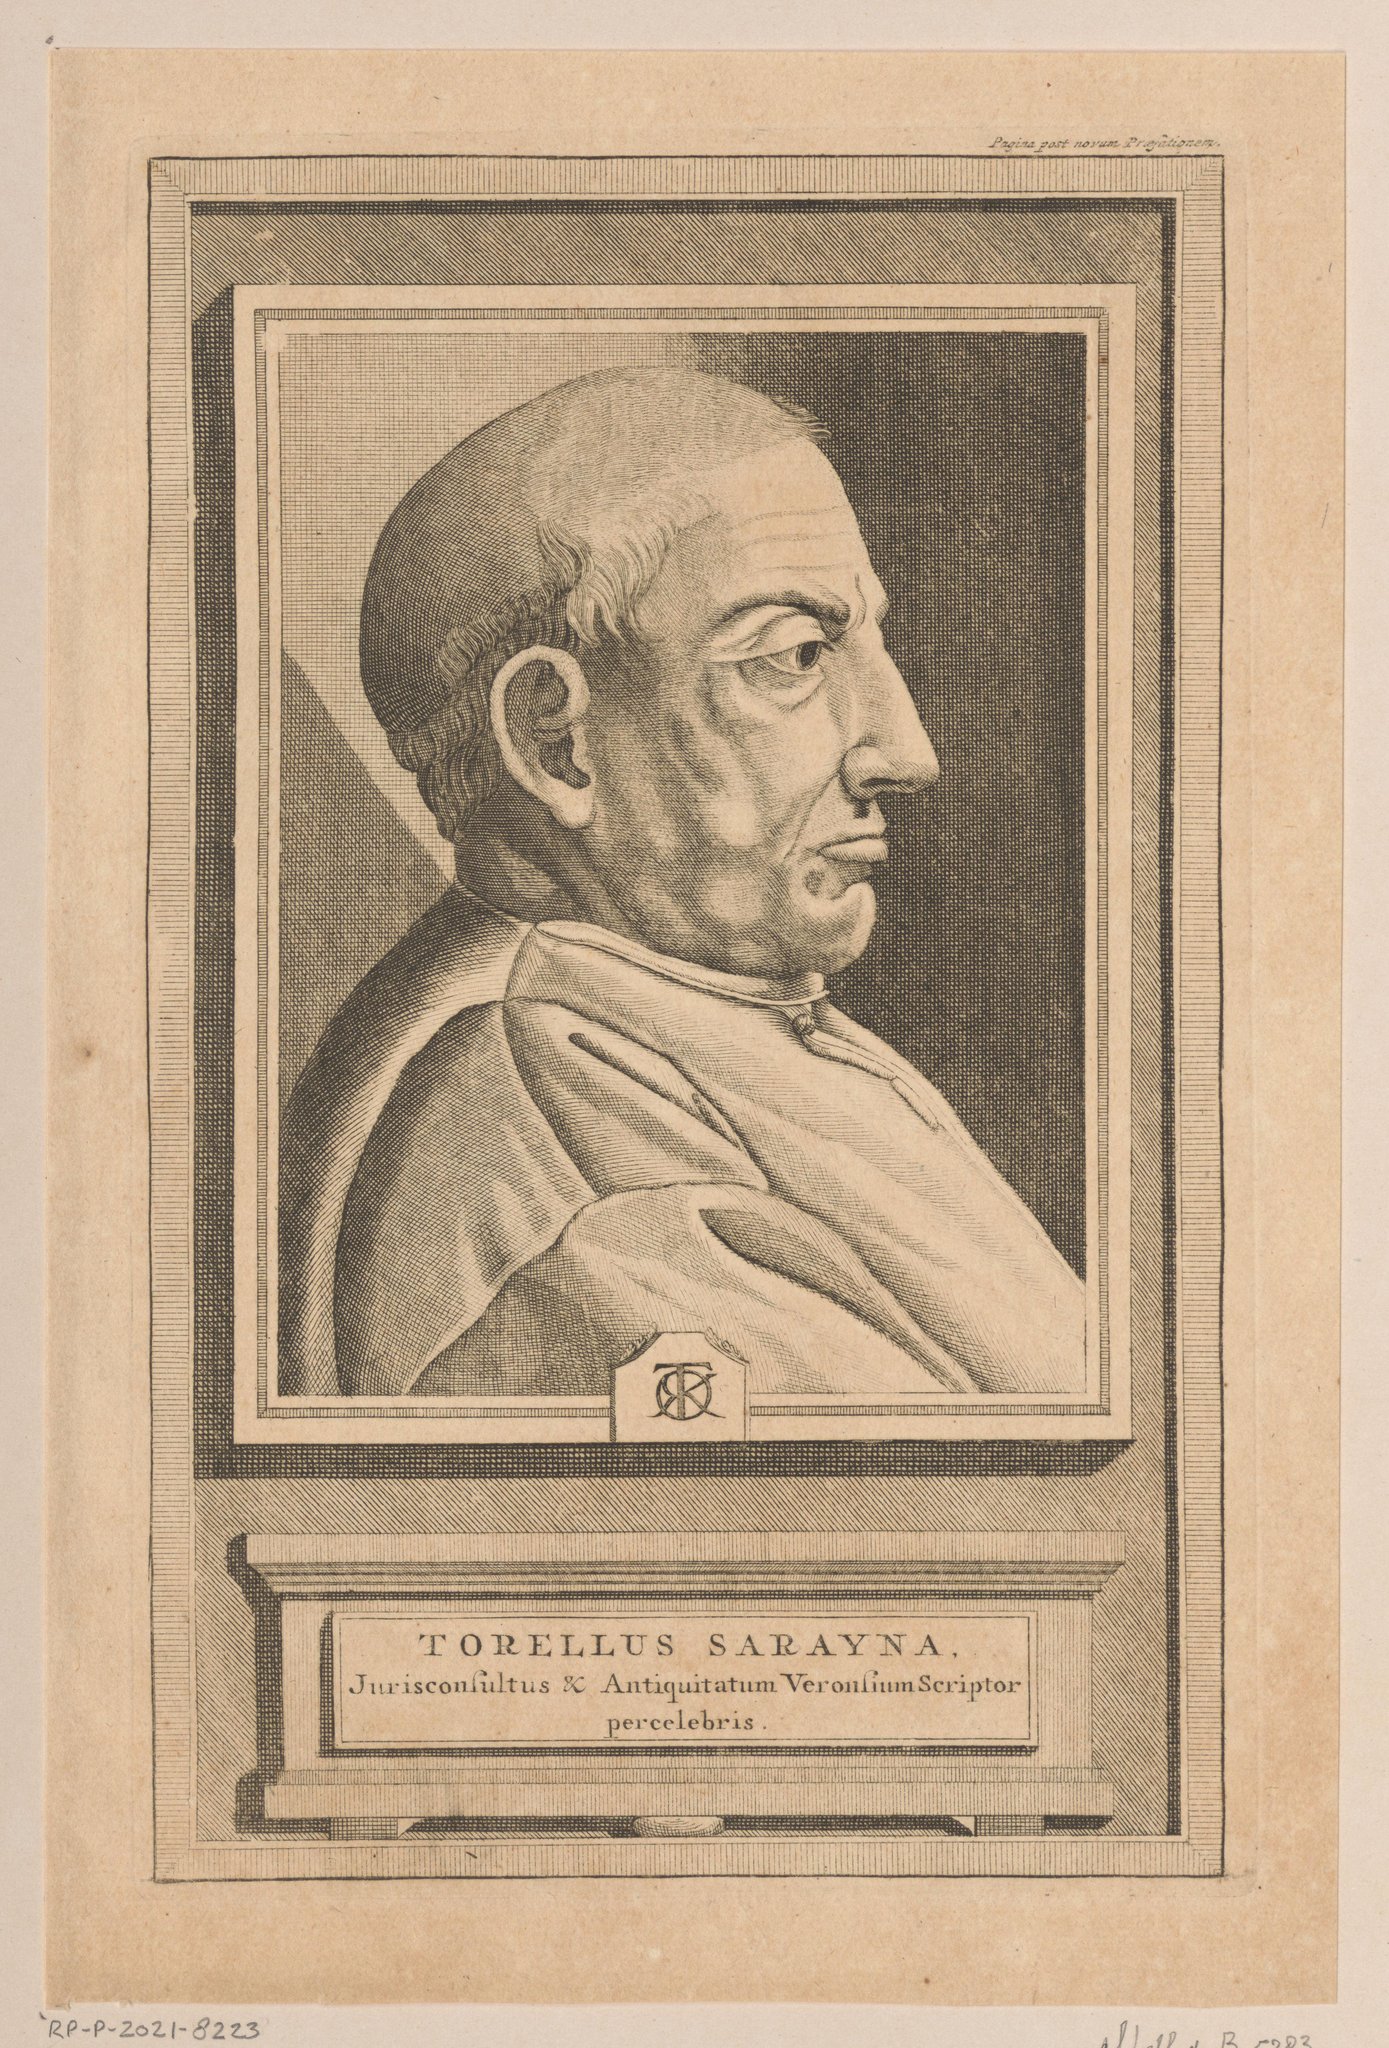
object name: print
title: Portret van Torello Saraina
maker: Anonymous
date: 1723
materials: paper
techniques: etching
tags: historical persons, portrait of a writer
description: Prent waarschijnlijk uit: Graevius, Johann Georg. Thesaurus antiquitatum et historiarum Italiae, Neapolis, Siciliae, Sardiniae (...). Leiden: Pieter van der Aa, 1723, dl. 7.